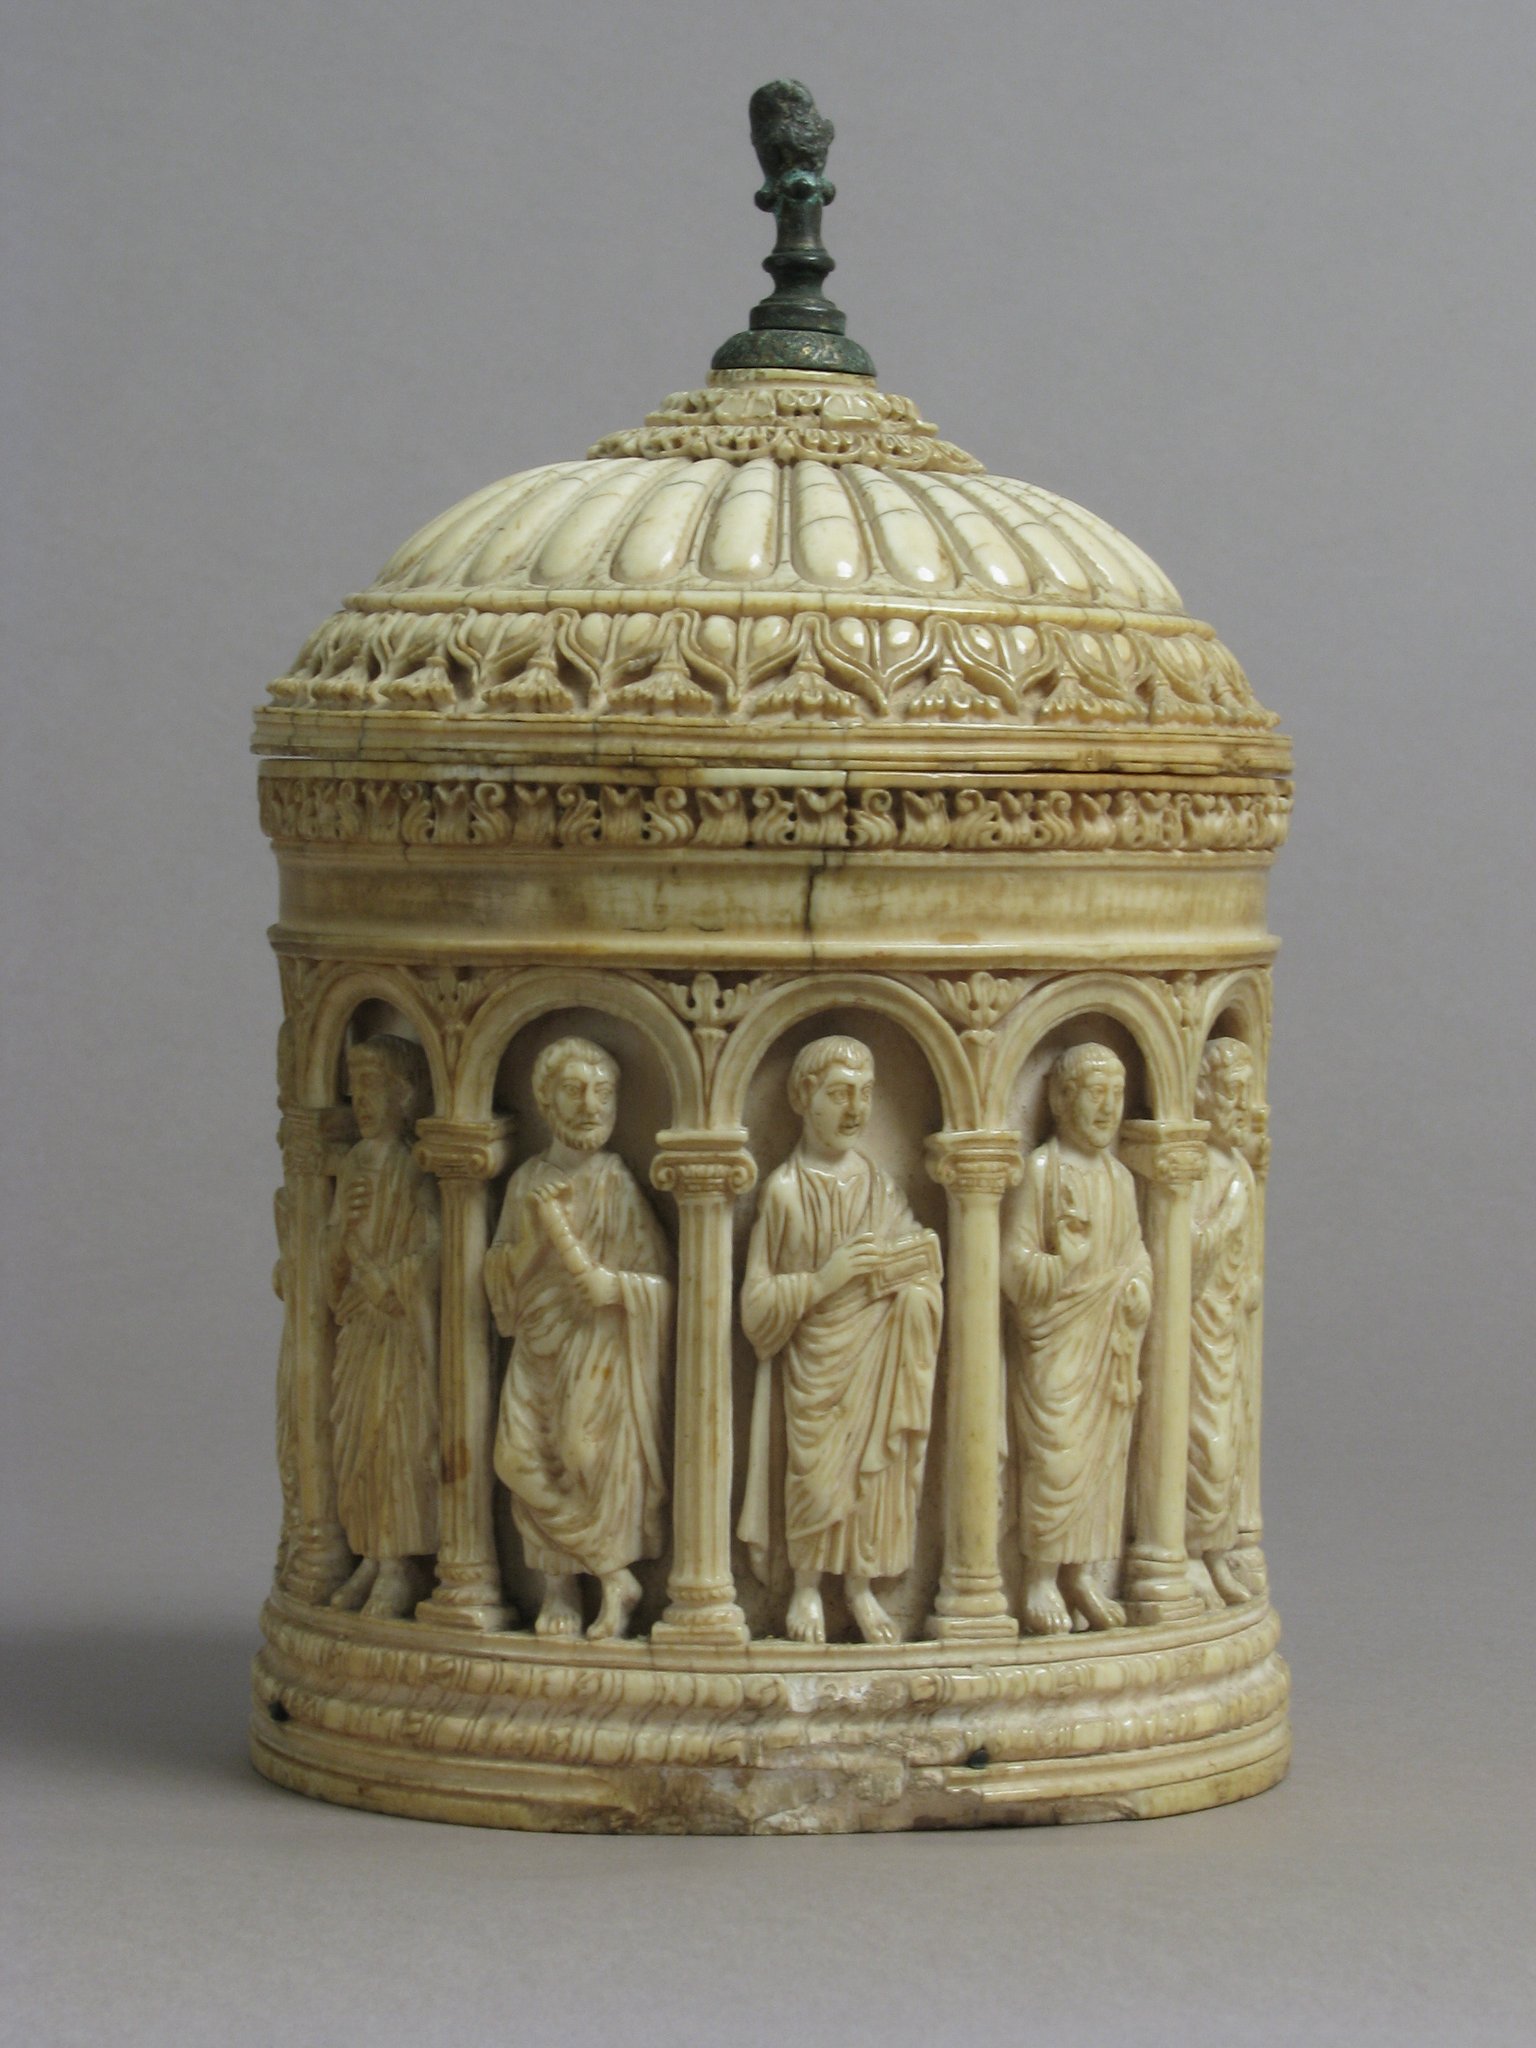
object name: container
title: Container with Figures under an Arcade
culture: european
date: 1801-1900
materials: ivory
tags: men